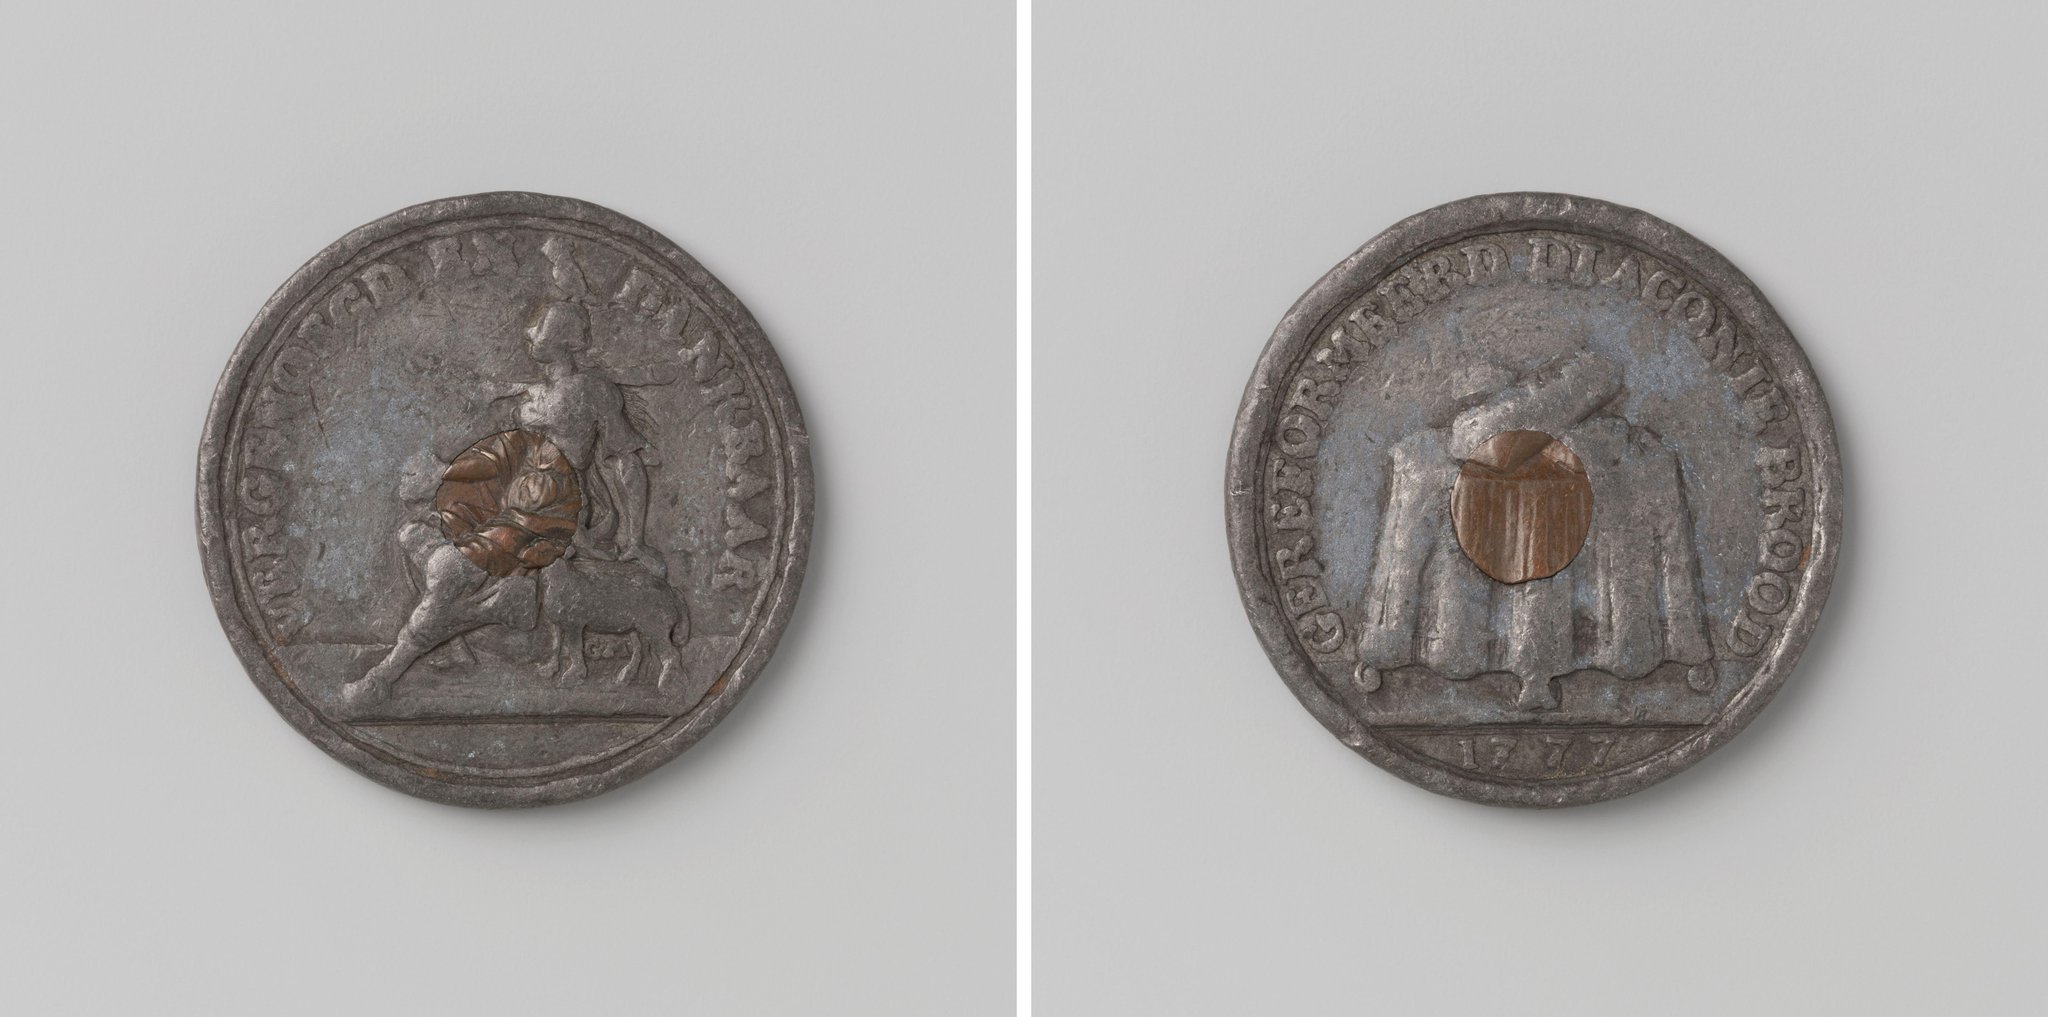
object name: broodpenning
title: Gereformeerde Diakonie te Amsterdam, armenpenning die behoeftige kerklidmaten bij uitdeling recht gaf op brood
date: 1777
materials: copper, lead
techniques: striking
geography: amsterdam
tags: amsterdam